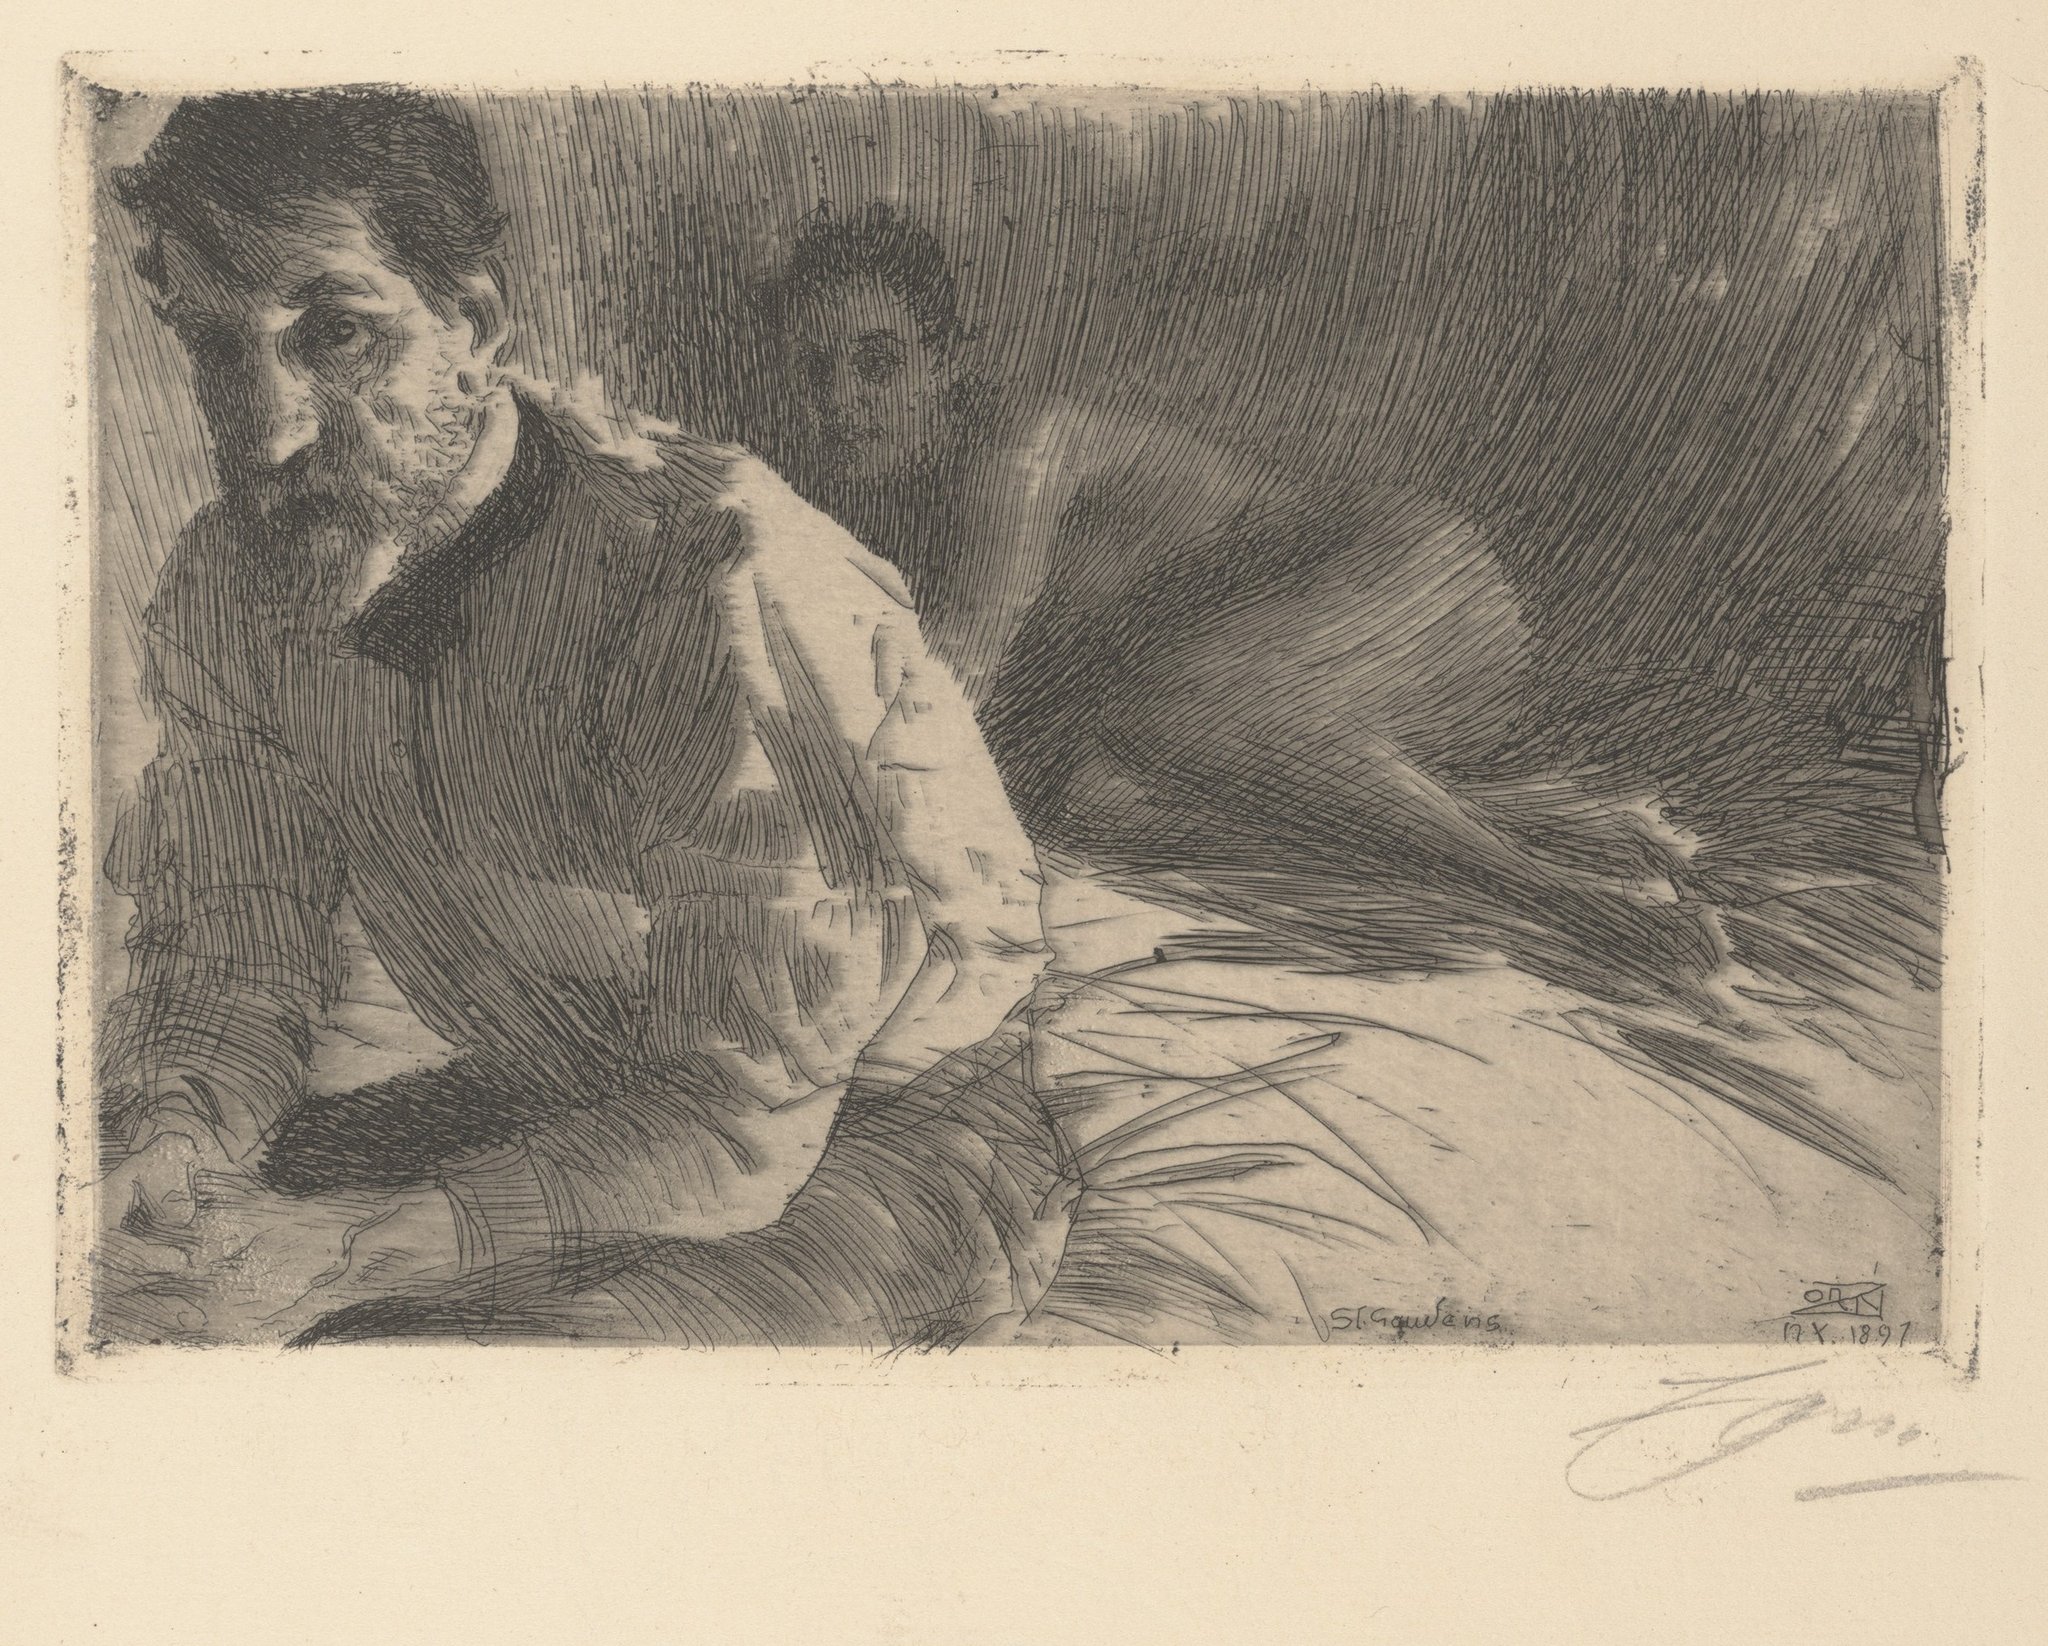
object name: print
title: Augustus Saint Gaudens II (Saint Gaudens and his Model)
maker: anders zorn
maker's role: artist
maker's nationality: swedish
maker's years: 1860-1920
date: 1897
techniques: drypoint, etching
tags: men,female nudes